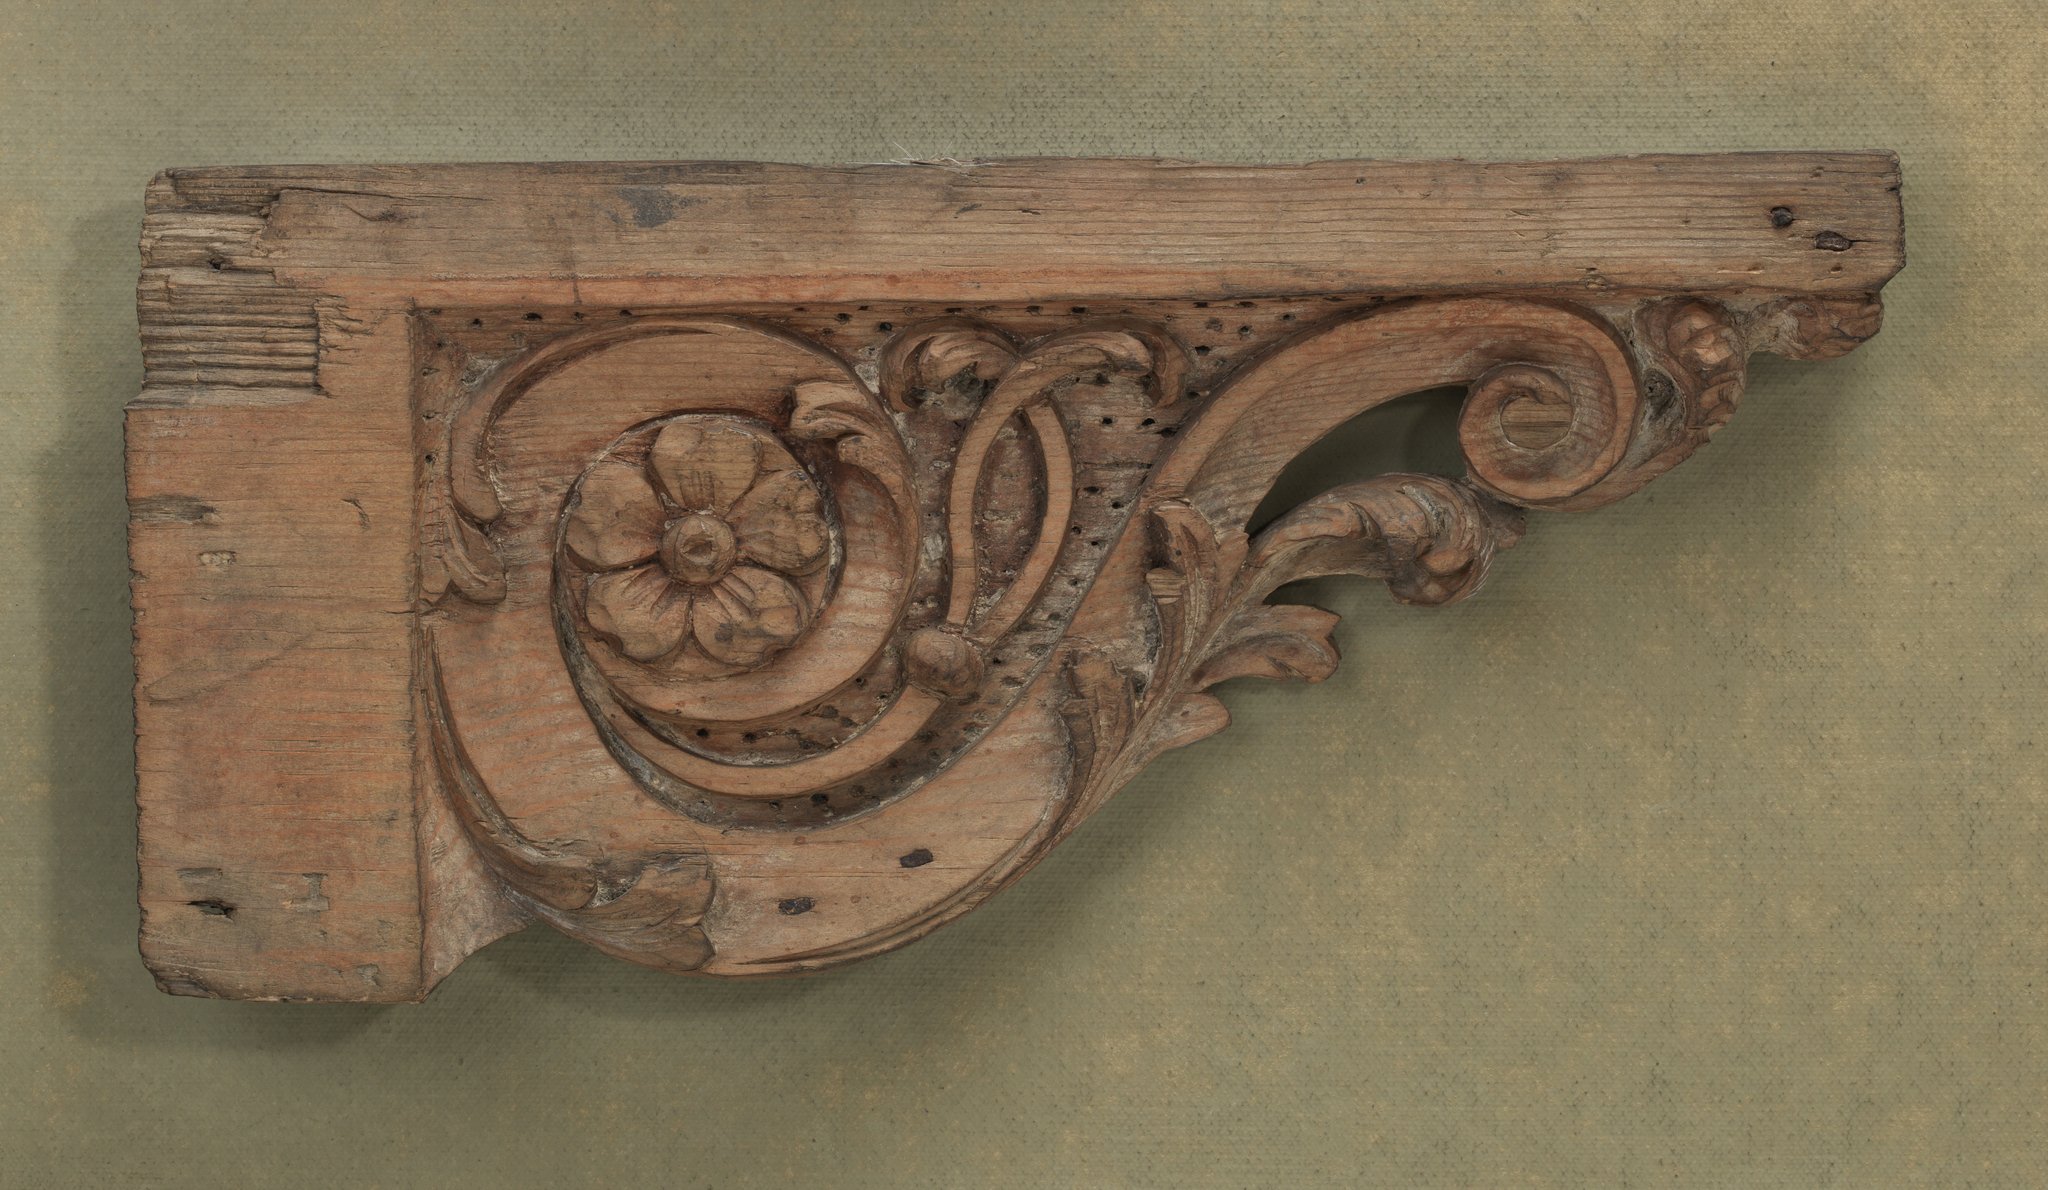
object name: bracket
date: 1701-1800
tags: flowers